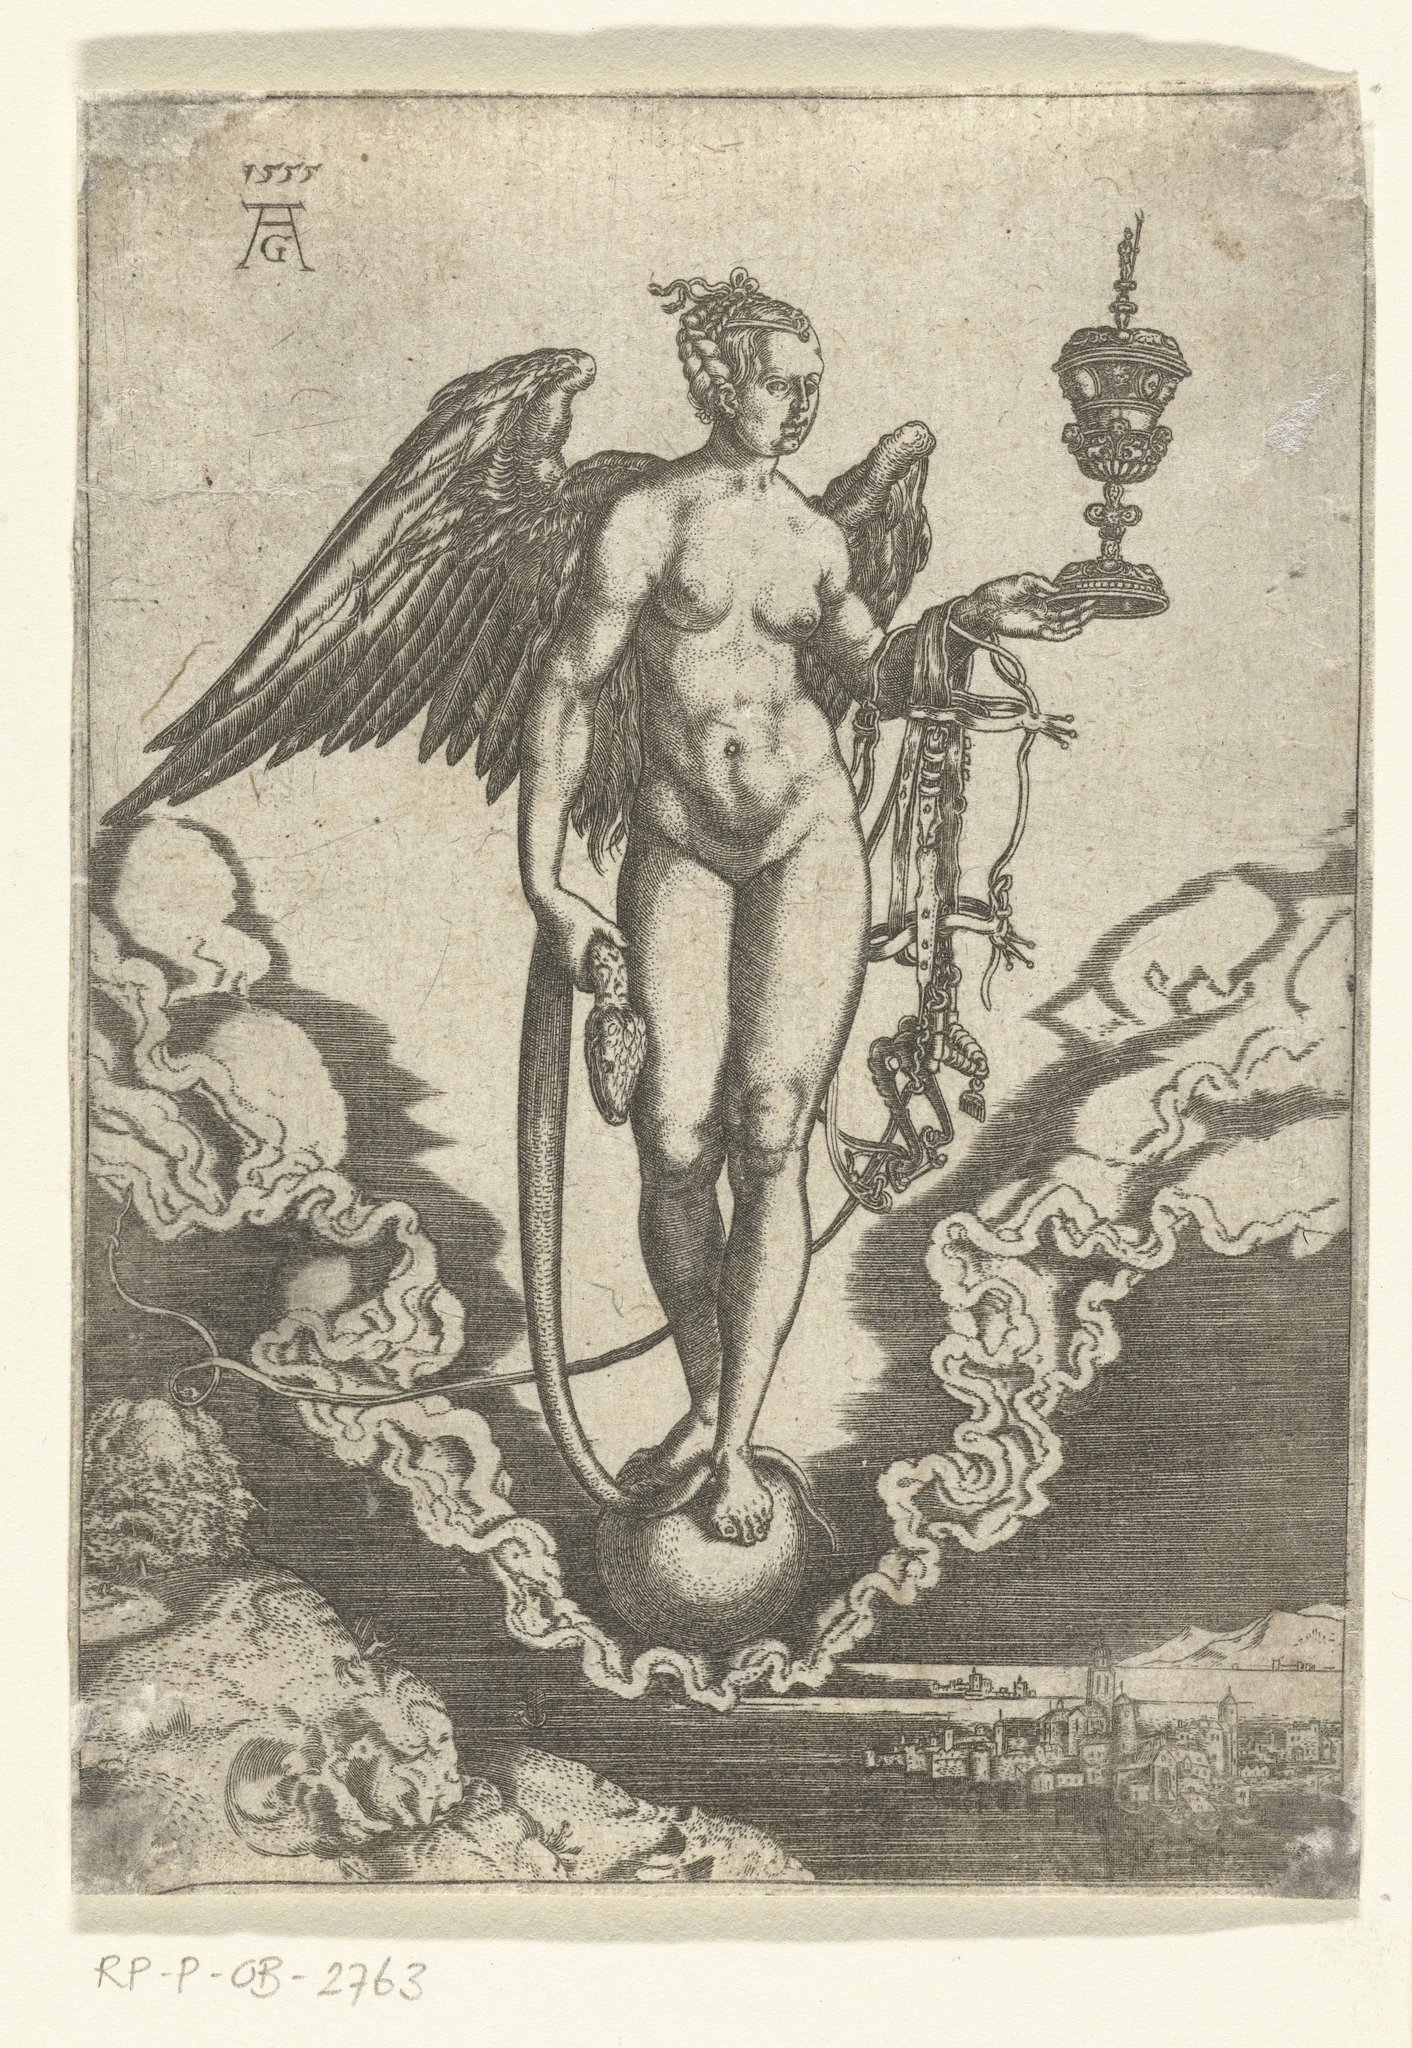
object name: print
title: Fortuna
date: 1555-1610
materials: paper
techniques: engraving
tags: luck, fortune, lot; 'fato', 'fortuna', 'fortuna aurea', 'fortuna buona', 'fortuna pacifica overo clemente', 'sorte' (ripa)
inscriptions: collector's mark: Lugt 700, collector's mark: Lugt 2166, collector's mark: Lugt 240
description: De godin Fortuna, naakt en gevleugeld, staand op een bol in een wolk. In haar linkerhand houdt zij een slang, in haar rechterhand een rijk versierde beker, om haar arm hangt een paardenhoofdstel.